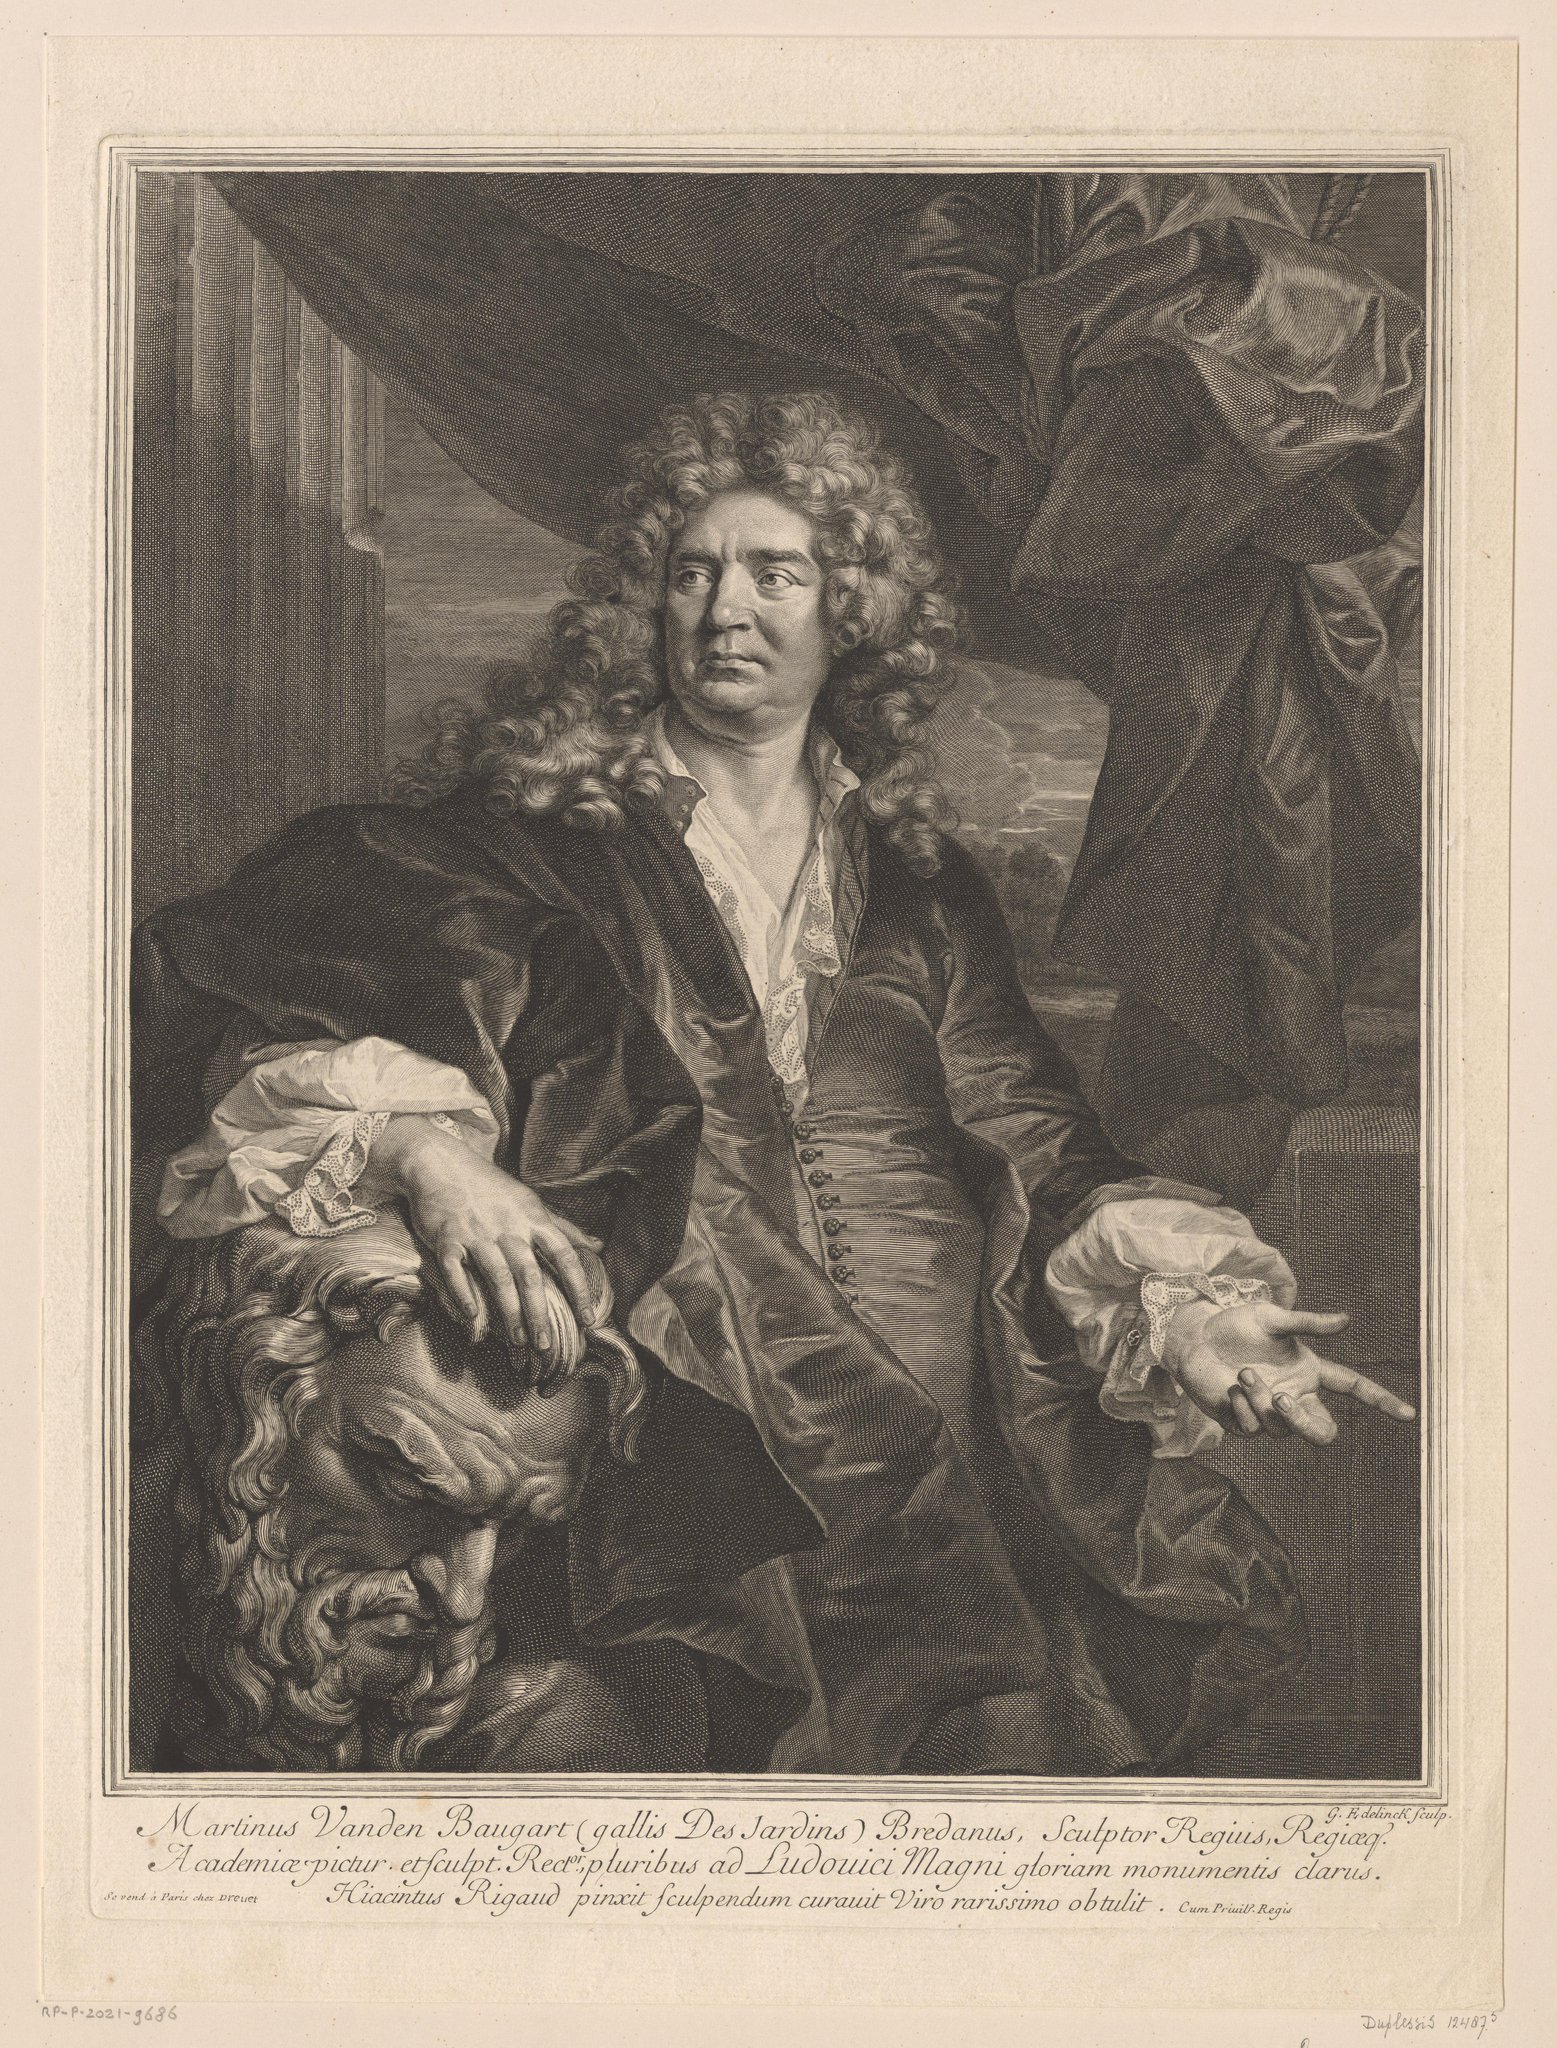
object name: print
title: Portret van Martin Desjardins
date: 1673-1707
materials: paper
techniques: engraving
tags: sculptor, martin desjardins, portrait, self-portrait of sculptor, historical persons, sculpture